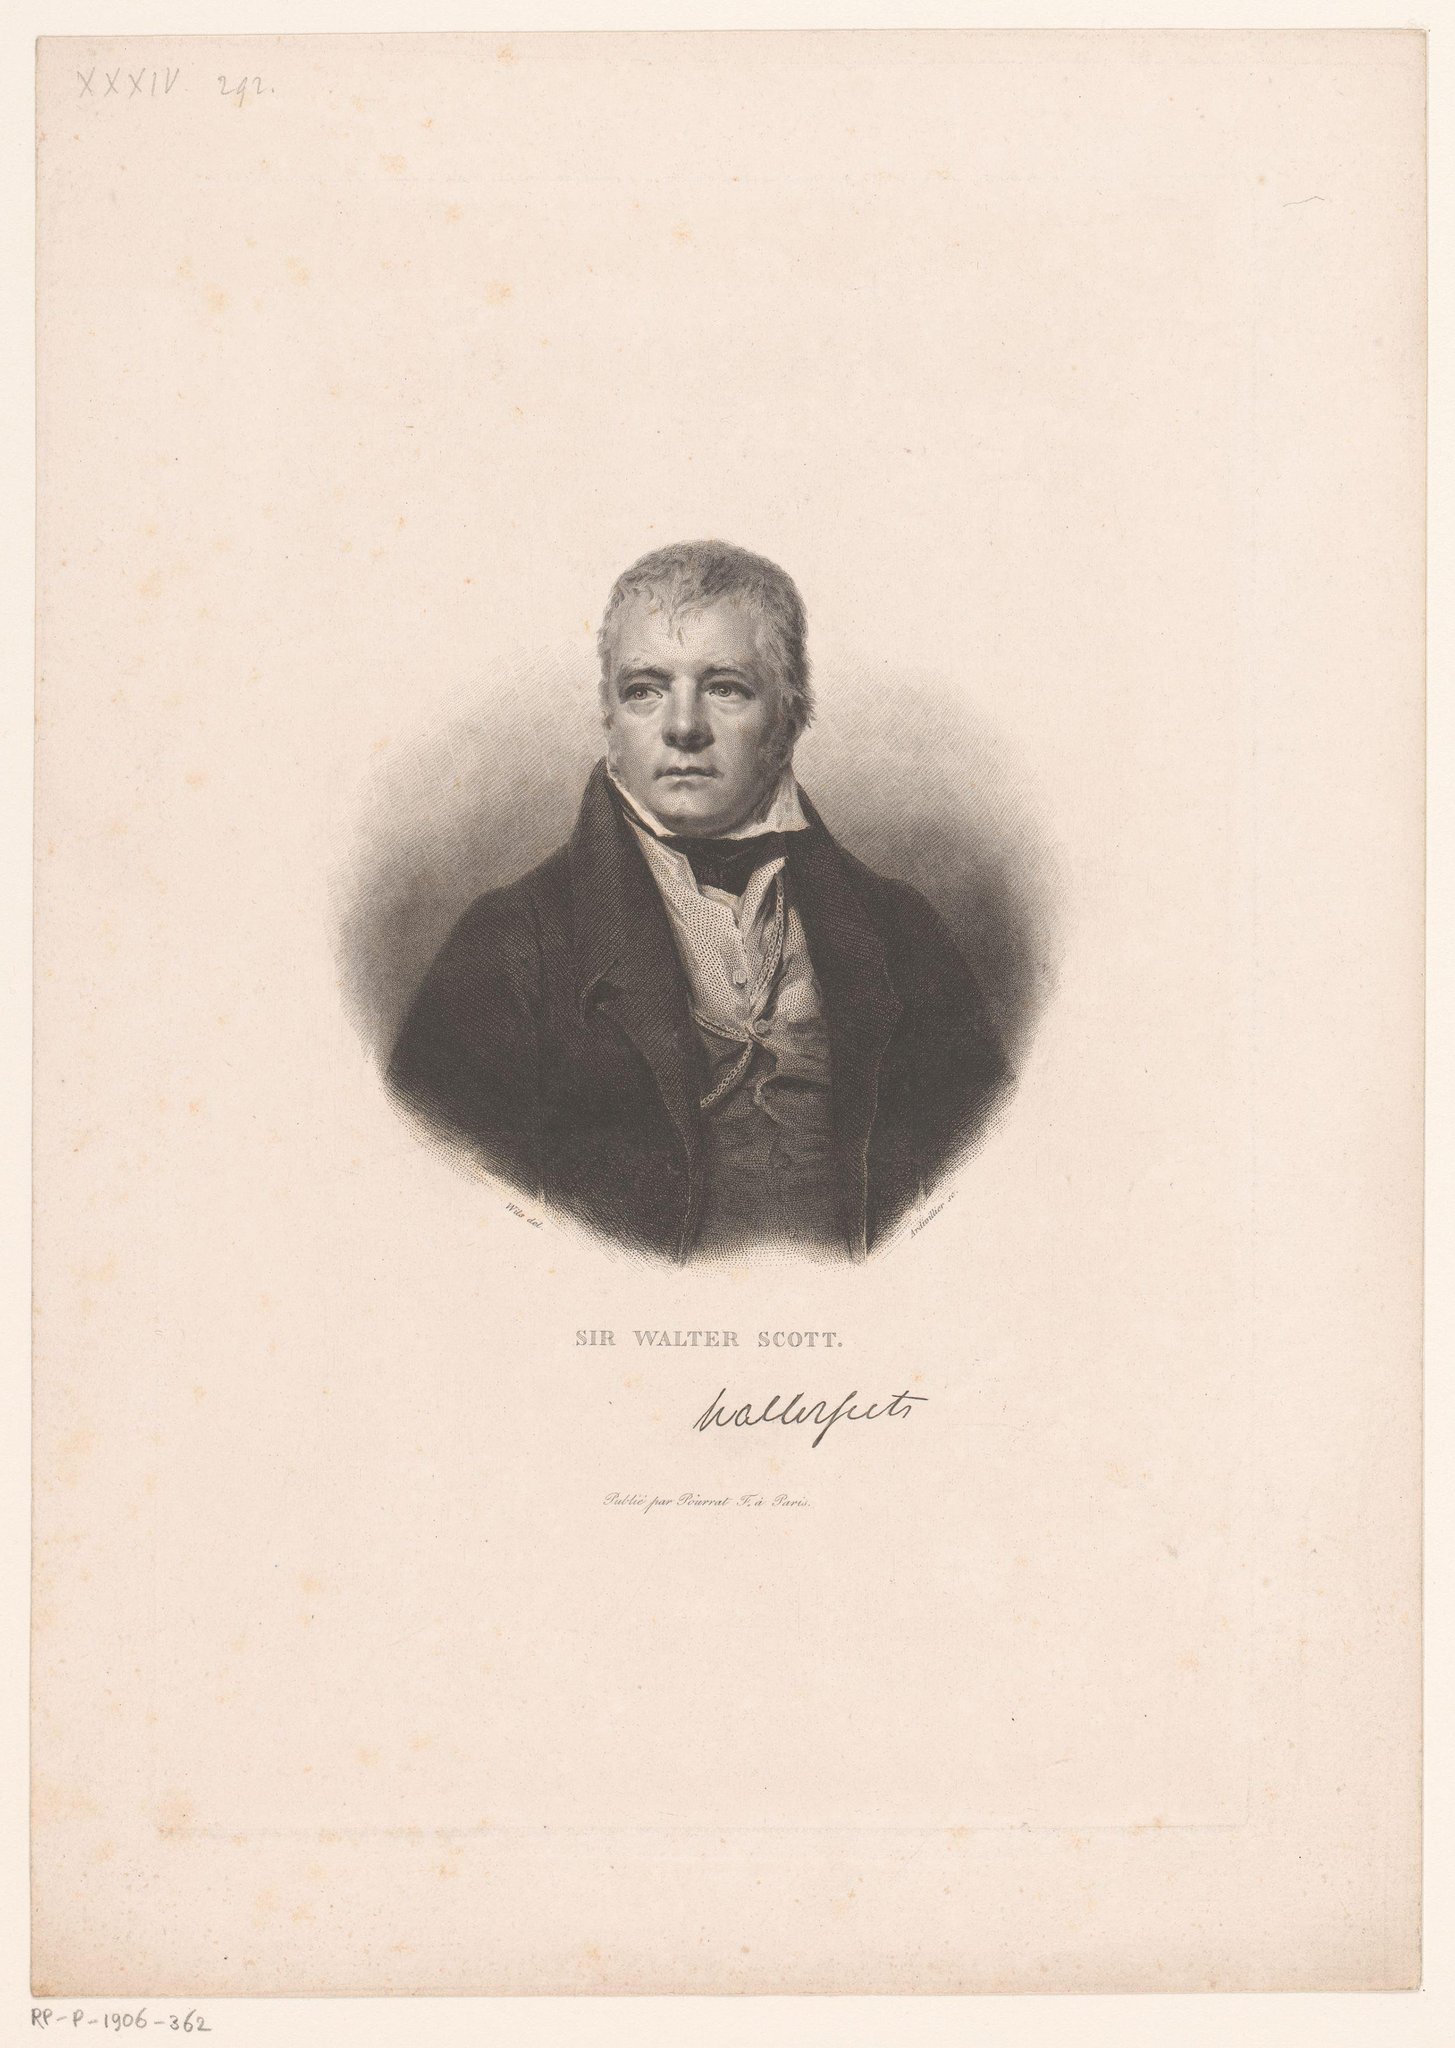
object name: print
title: Portret van Sir Walter Scott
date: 1805-1840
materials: paper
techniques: etching, roulette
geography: paris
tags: walter scott, historical persons, portrait of a writer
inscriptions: collector's mark: Lugt 2228